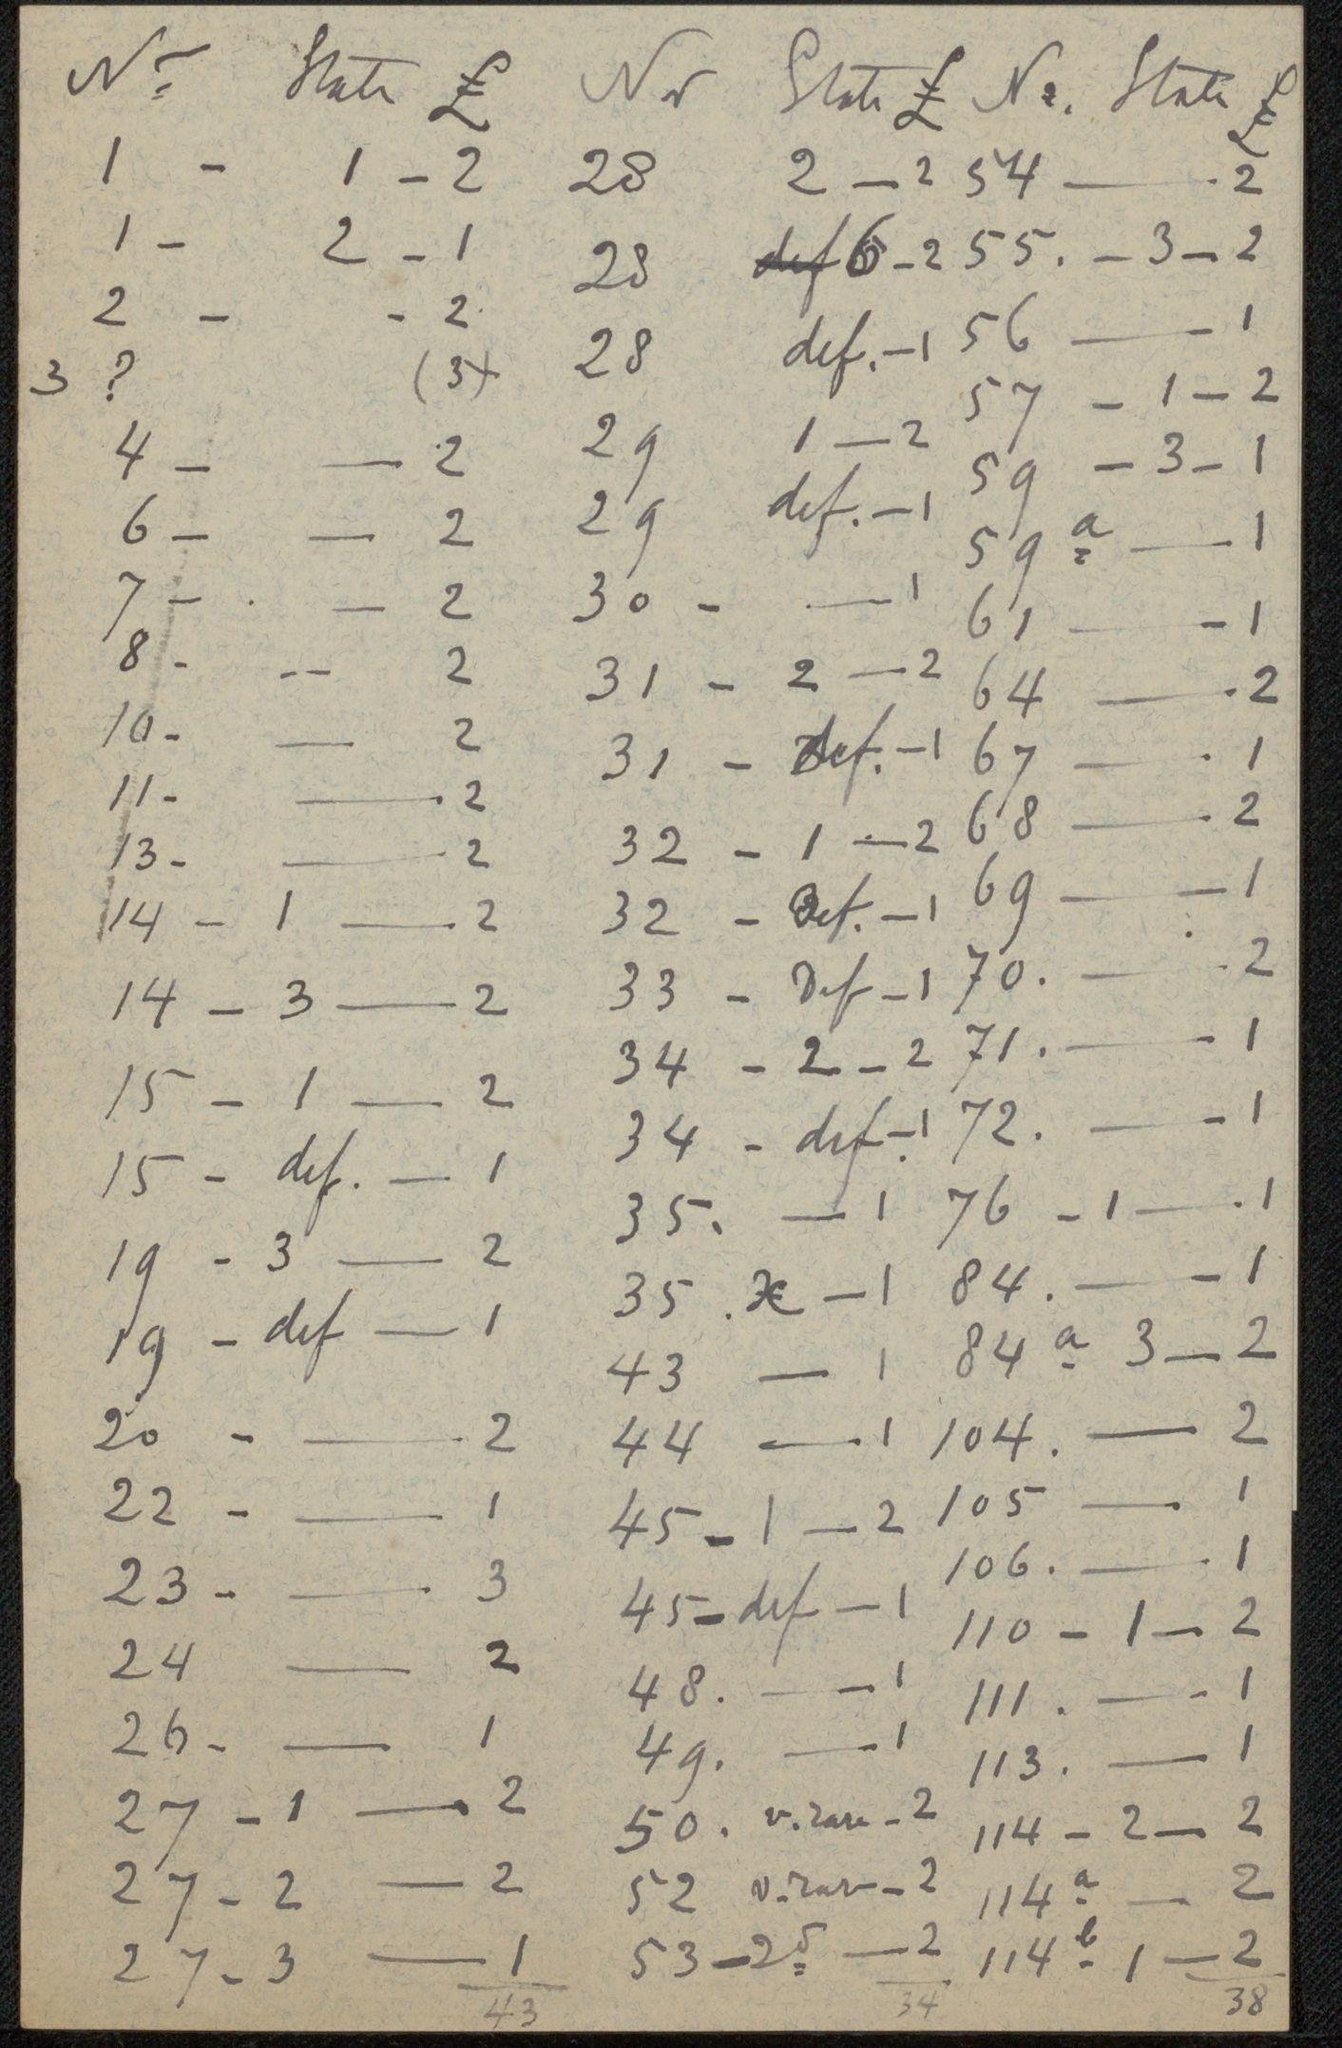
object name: aantekening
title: Aantekening uit archief Philip Zilcken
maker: philip zilcken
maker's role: draughtsman, painter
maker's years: 1857-1930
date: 1867-1930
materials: ink, paper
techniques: pen, writing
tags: the graphic arts, money